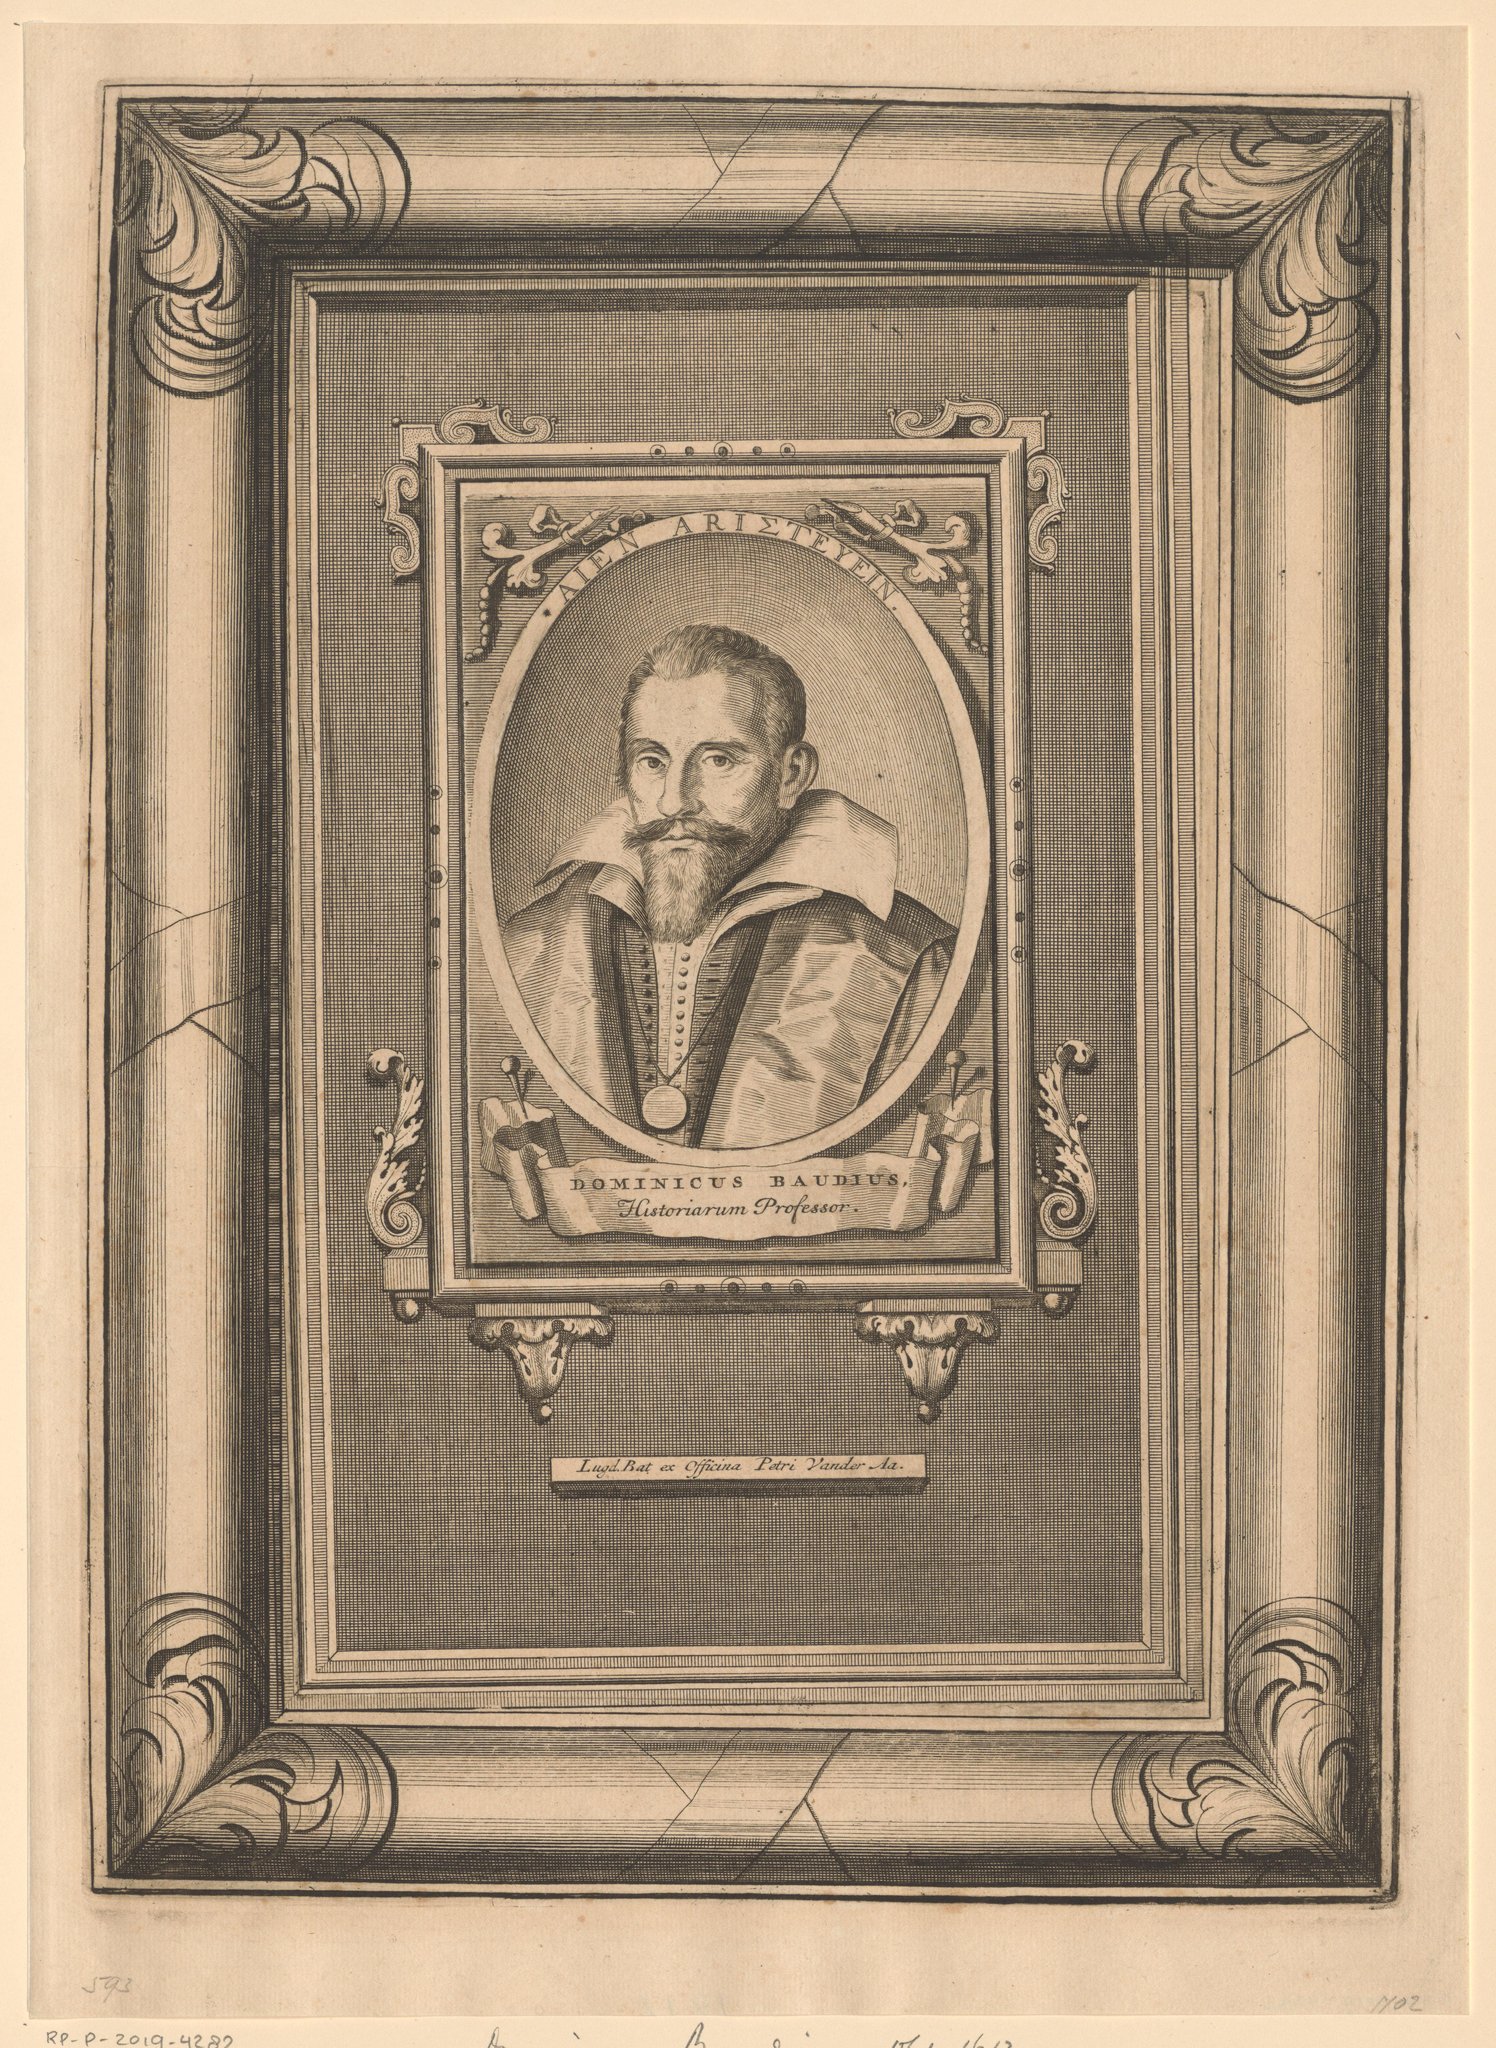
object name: print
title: Portret van Dominicus Baudius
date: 1716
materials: paper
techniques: engraving, etching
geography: leiden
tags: leiden, dominicus baudius, historical persons, writer, poet, author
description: Prent zonder dubbele omlijsting verschenen in: Fundatoris, curatorum et professorum celeberrimorum aliorumque illustrium virorum, quorum gratia, favore, cura, doctrinaque Academia Lugduno-Batava (...). Leiden: Pieter van der Aa, [ca. 1716].